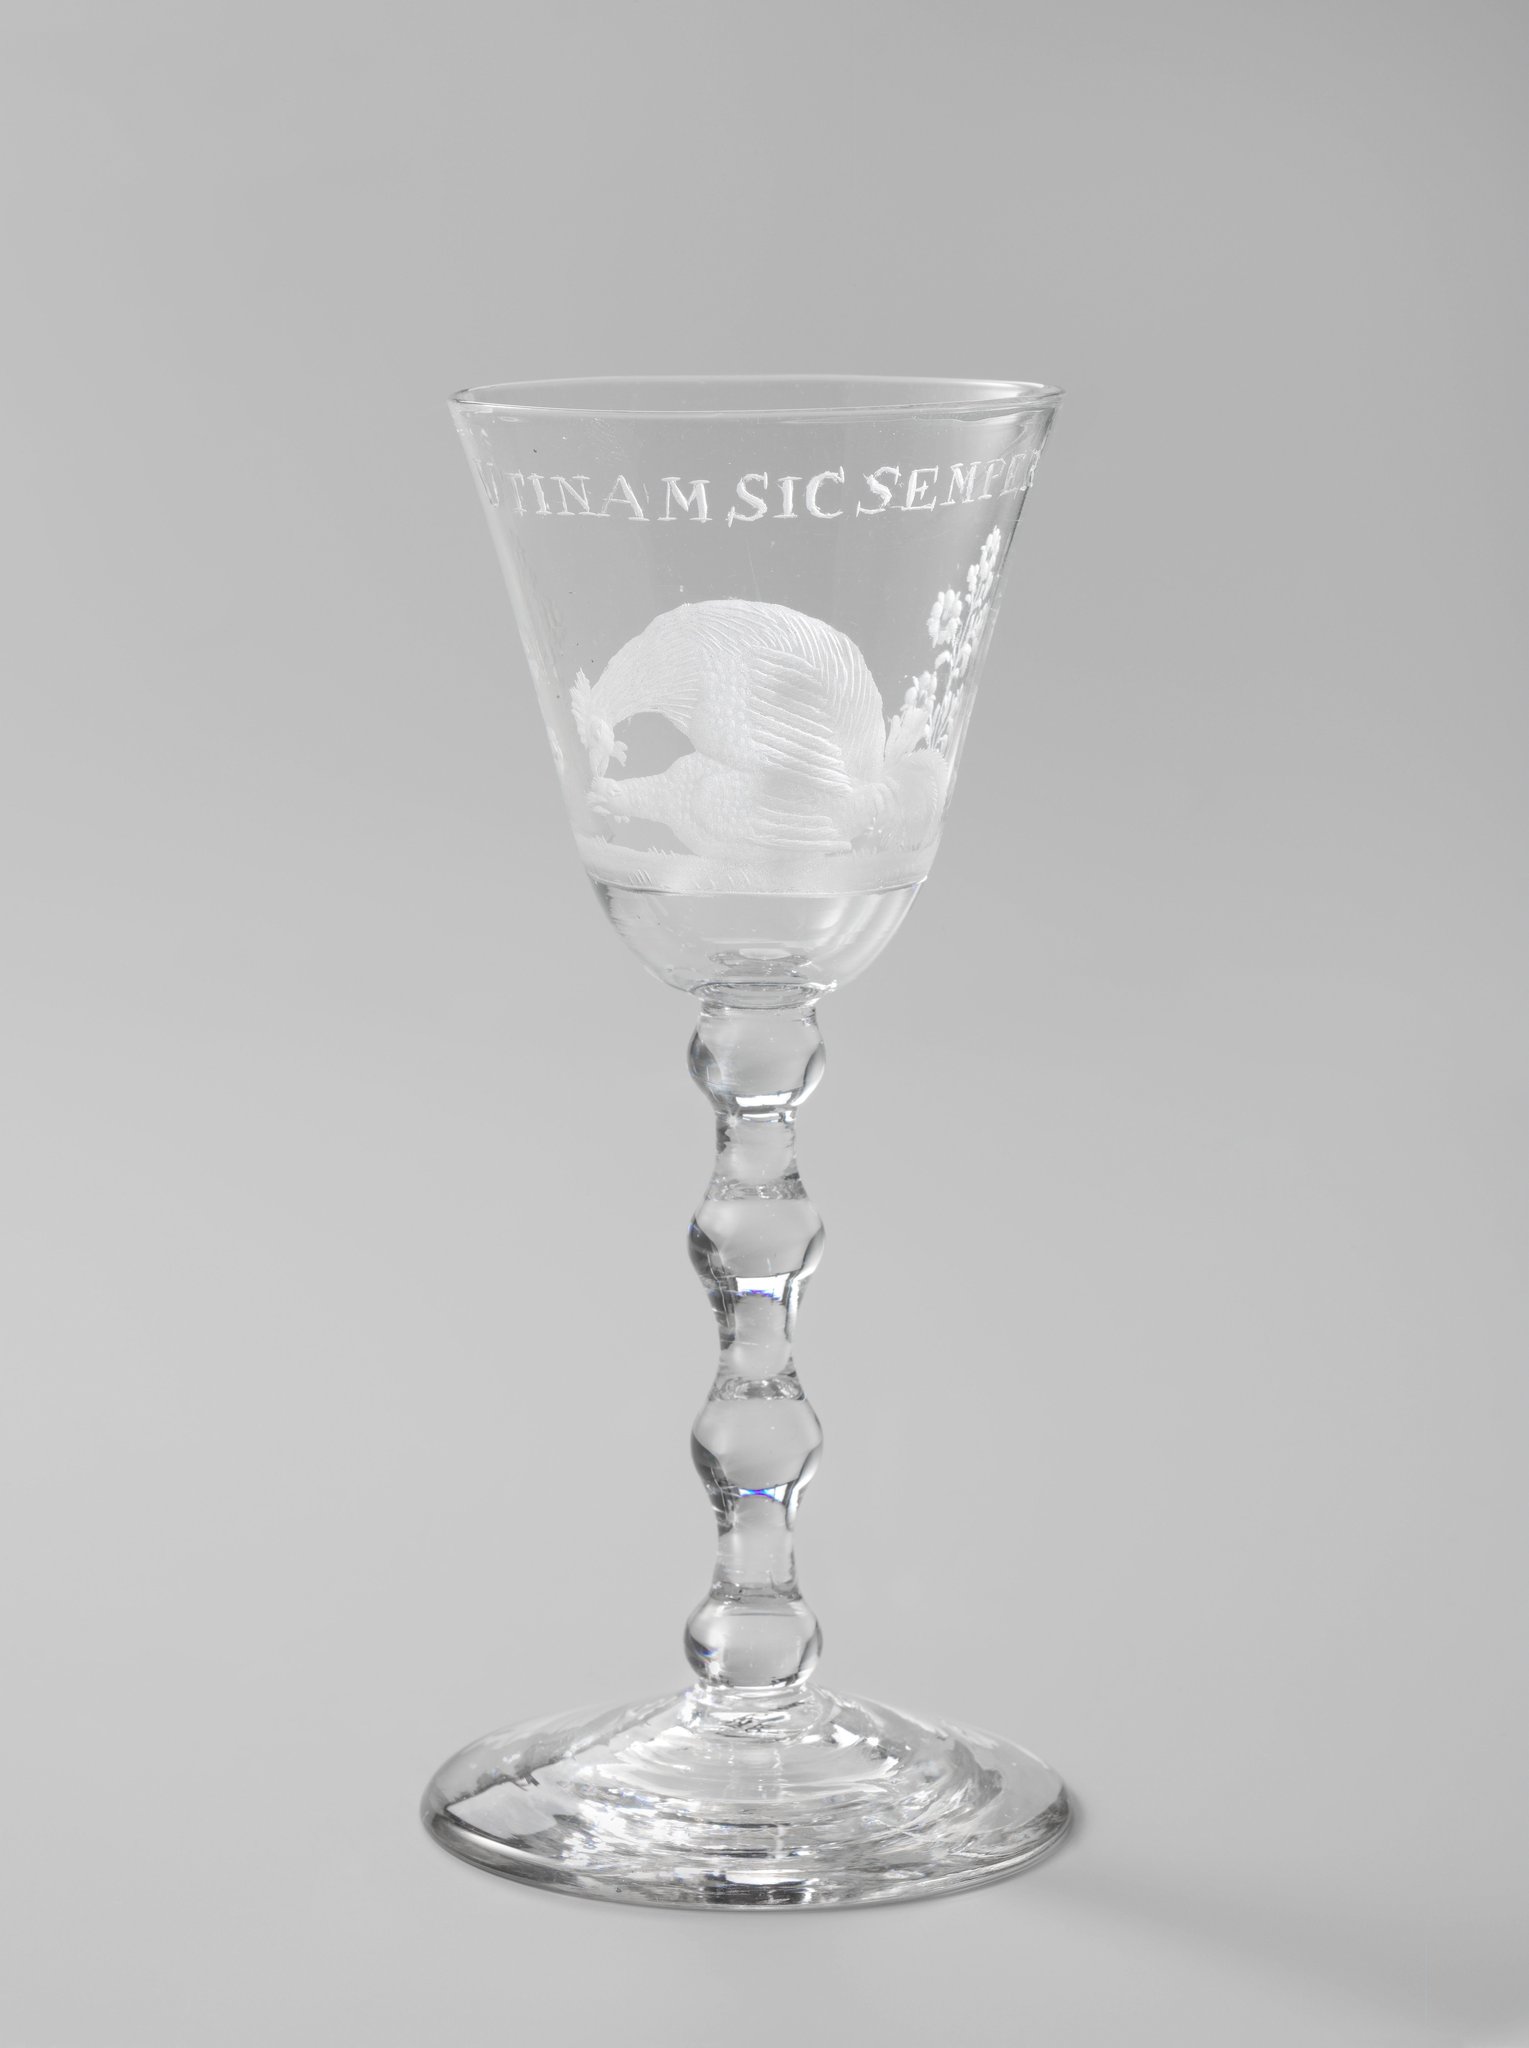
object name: goblet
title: Wine glass with a cockerel mating with a chicken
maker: Anonymous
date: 1725-1750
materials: glass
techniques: glassblowing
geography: northern netherlands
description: translation of inscription: May it always be so